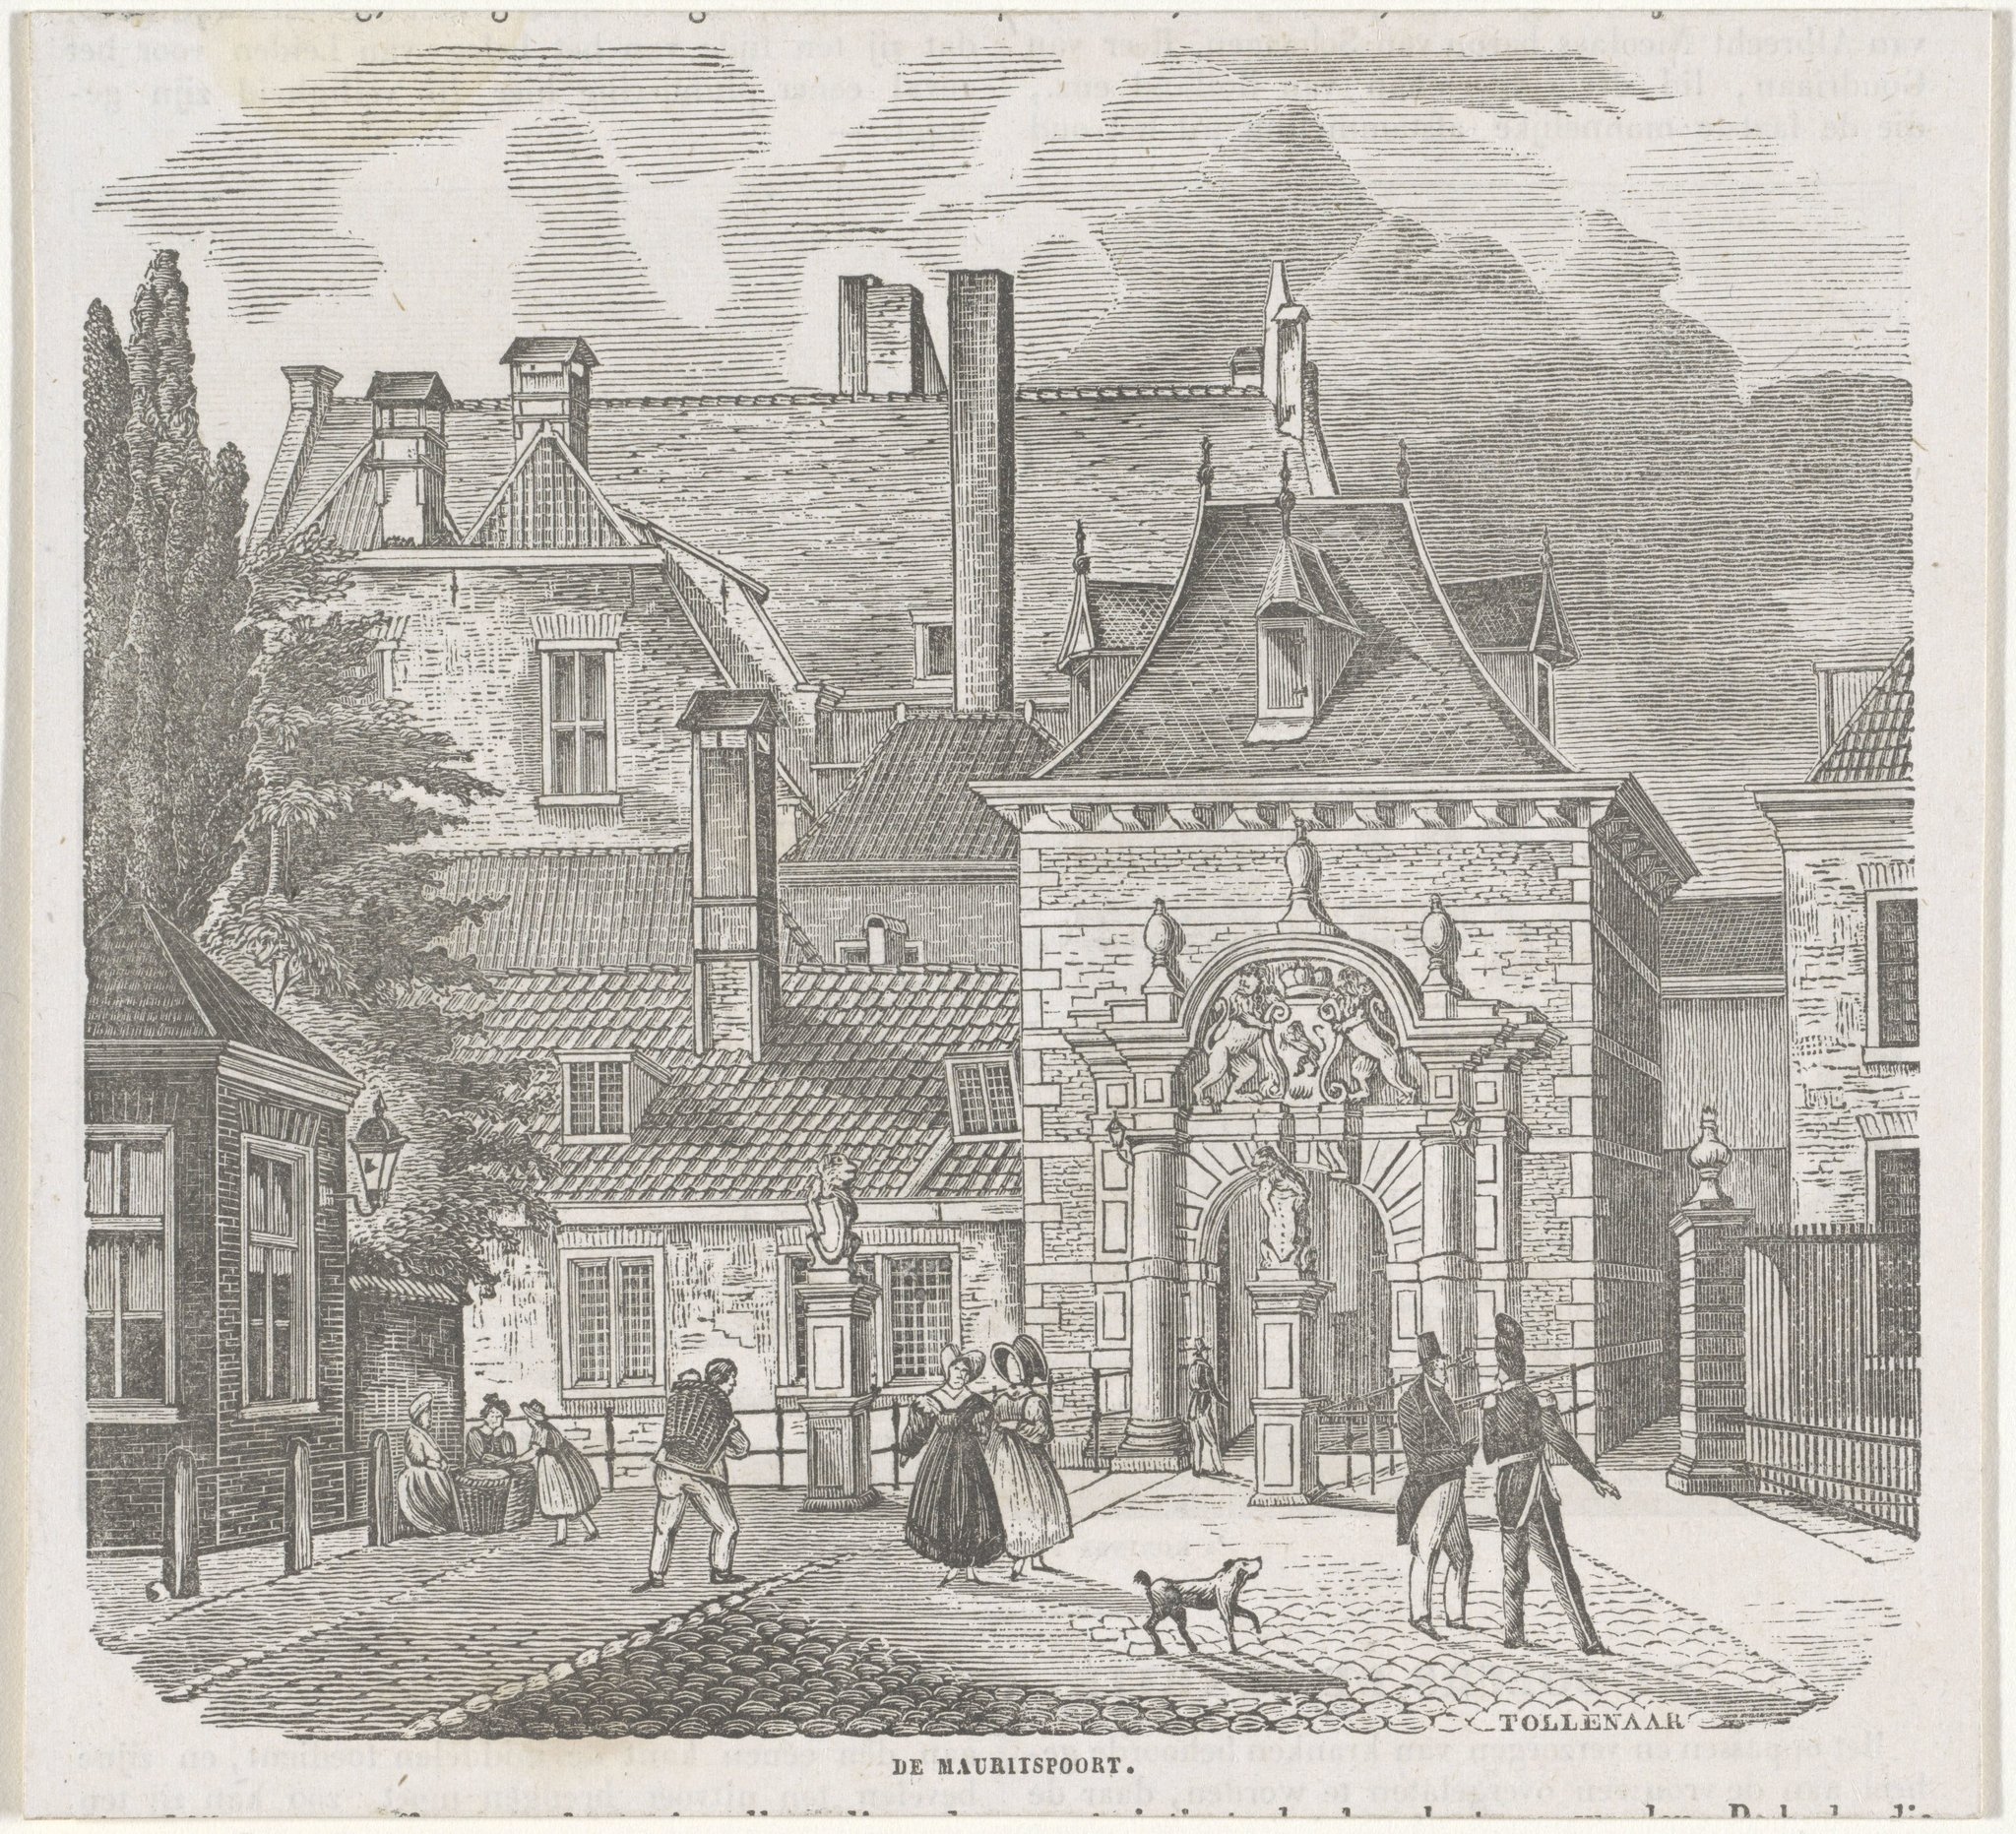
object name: book illustration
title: Mauritspoort aan het Binnenhof te Den Haag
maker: antonie vink tollenaar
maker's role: print maker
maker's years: 1805-1875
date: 1815-1875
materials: paper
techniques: letterpress printing, engraving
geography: netherlands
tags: gate, entrance, street (+ city(-scape) with figures, staffage)